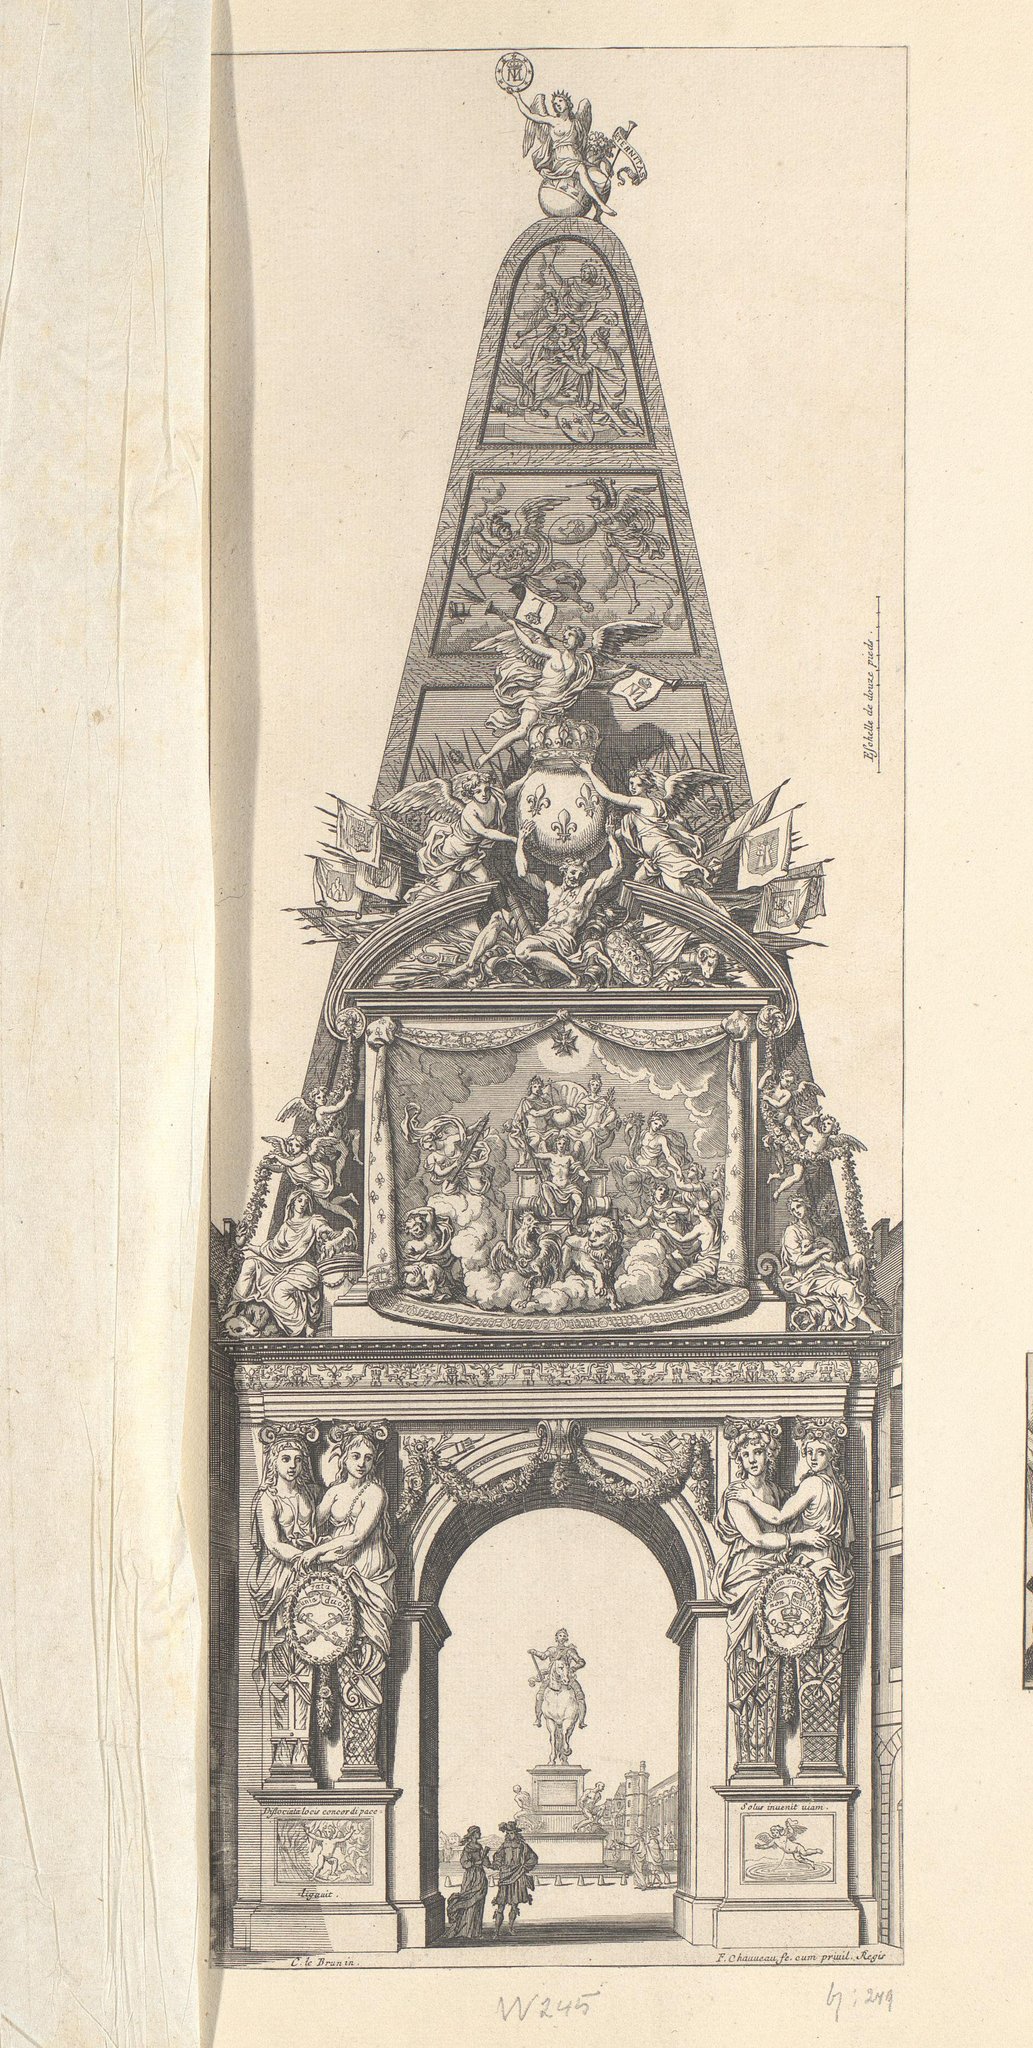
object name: print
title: Werken van Charles le Brun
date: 1662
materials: paper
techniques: engraving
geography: paris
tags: lodewijk xiv (koning van frankrijk), triumphal arch, paris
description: Prent uit: L'Entrée triomphale de Leurs Maiestez Louis XIV, Roy de France et de Nauarre, et Marie Therese d'Austriche, son espouse, dans la ville de Paris. Parijs: Pierre le Petit, Thomas Ioly en Louis Bilaine, [1662].